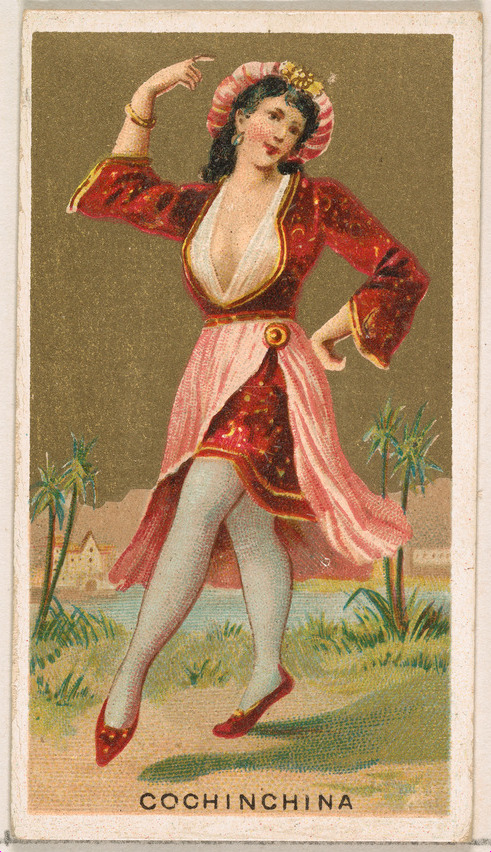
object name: print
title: Cochinchina, from the Dancing Girls of the World series (N185) issued by Wm. S. Kimball & Co.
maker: william s. kimball & company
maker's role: publisher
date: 1889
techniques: color lithograph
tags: women,dancing